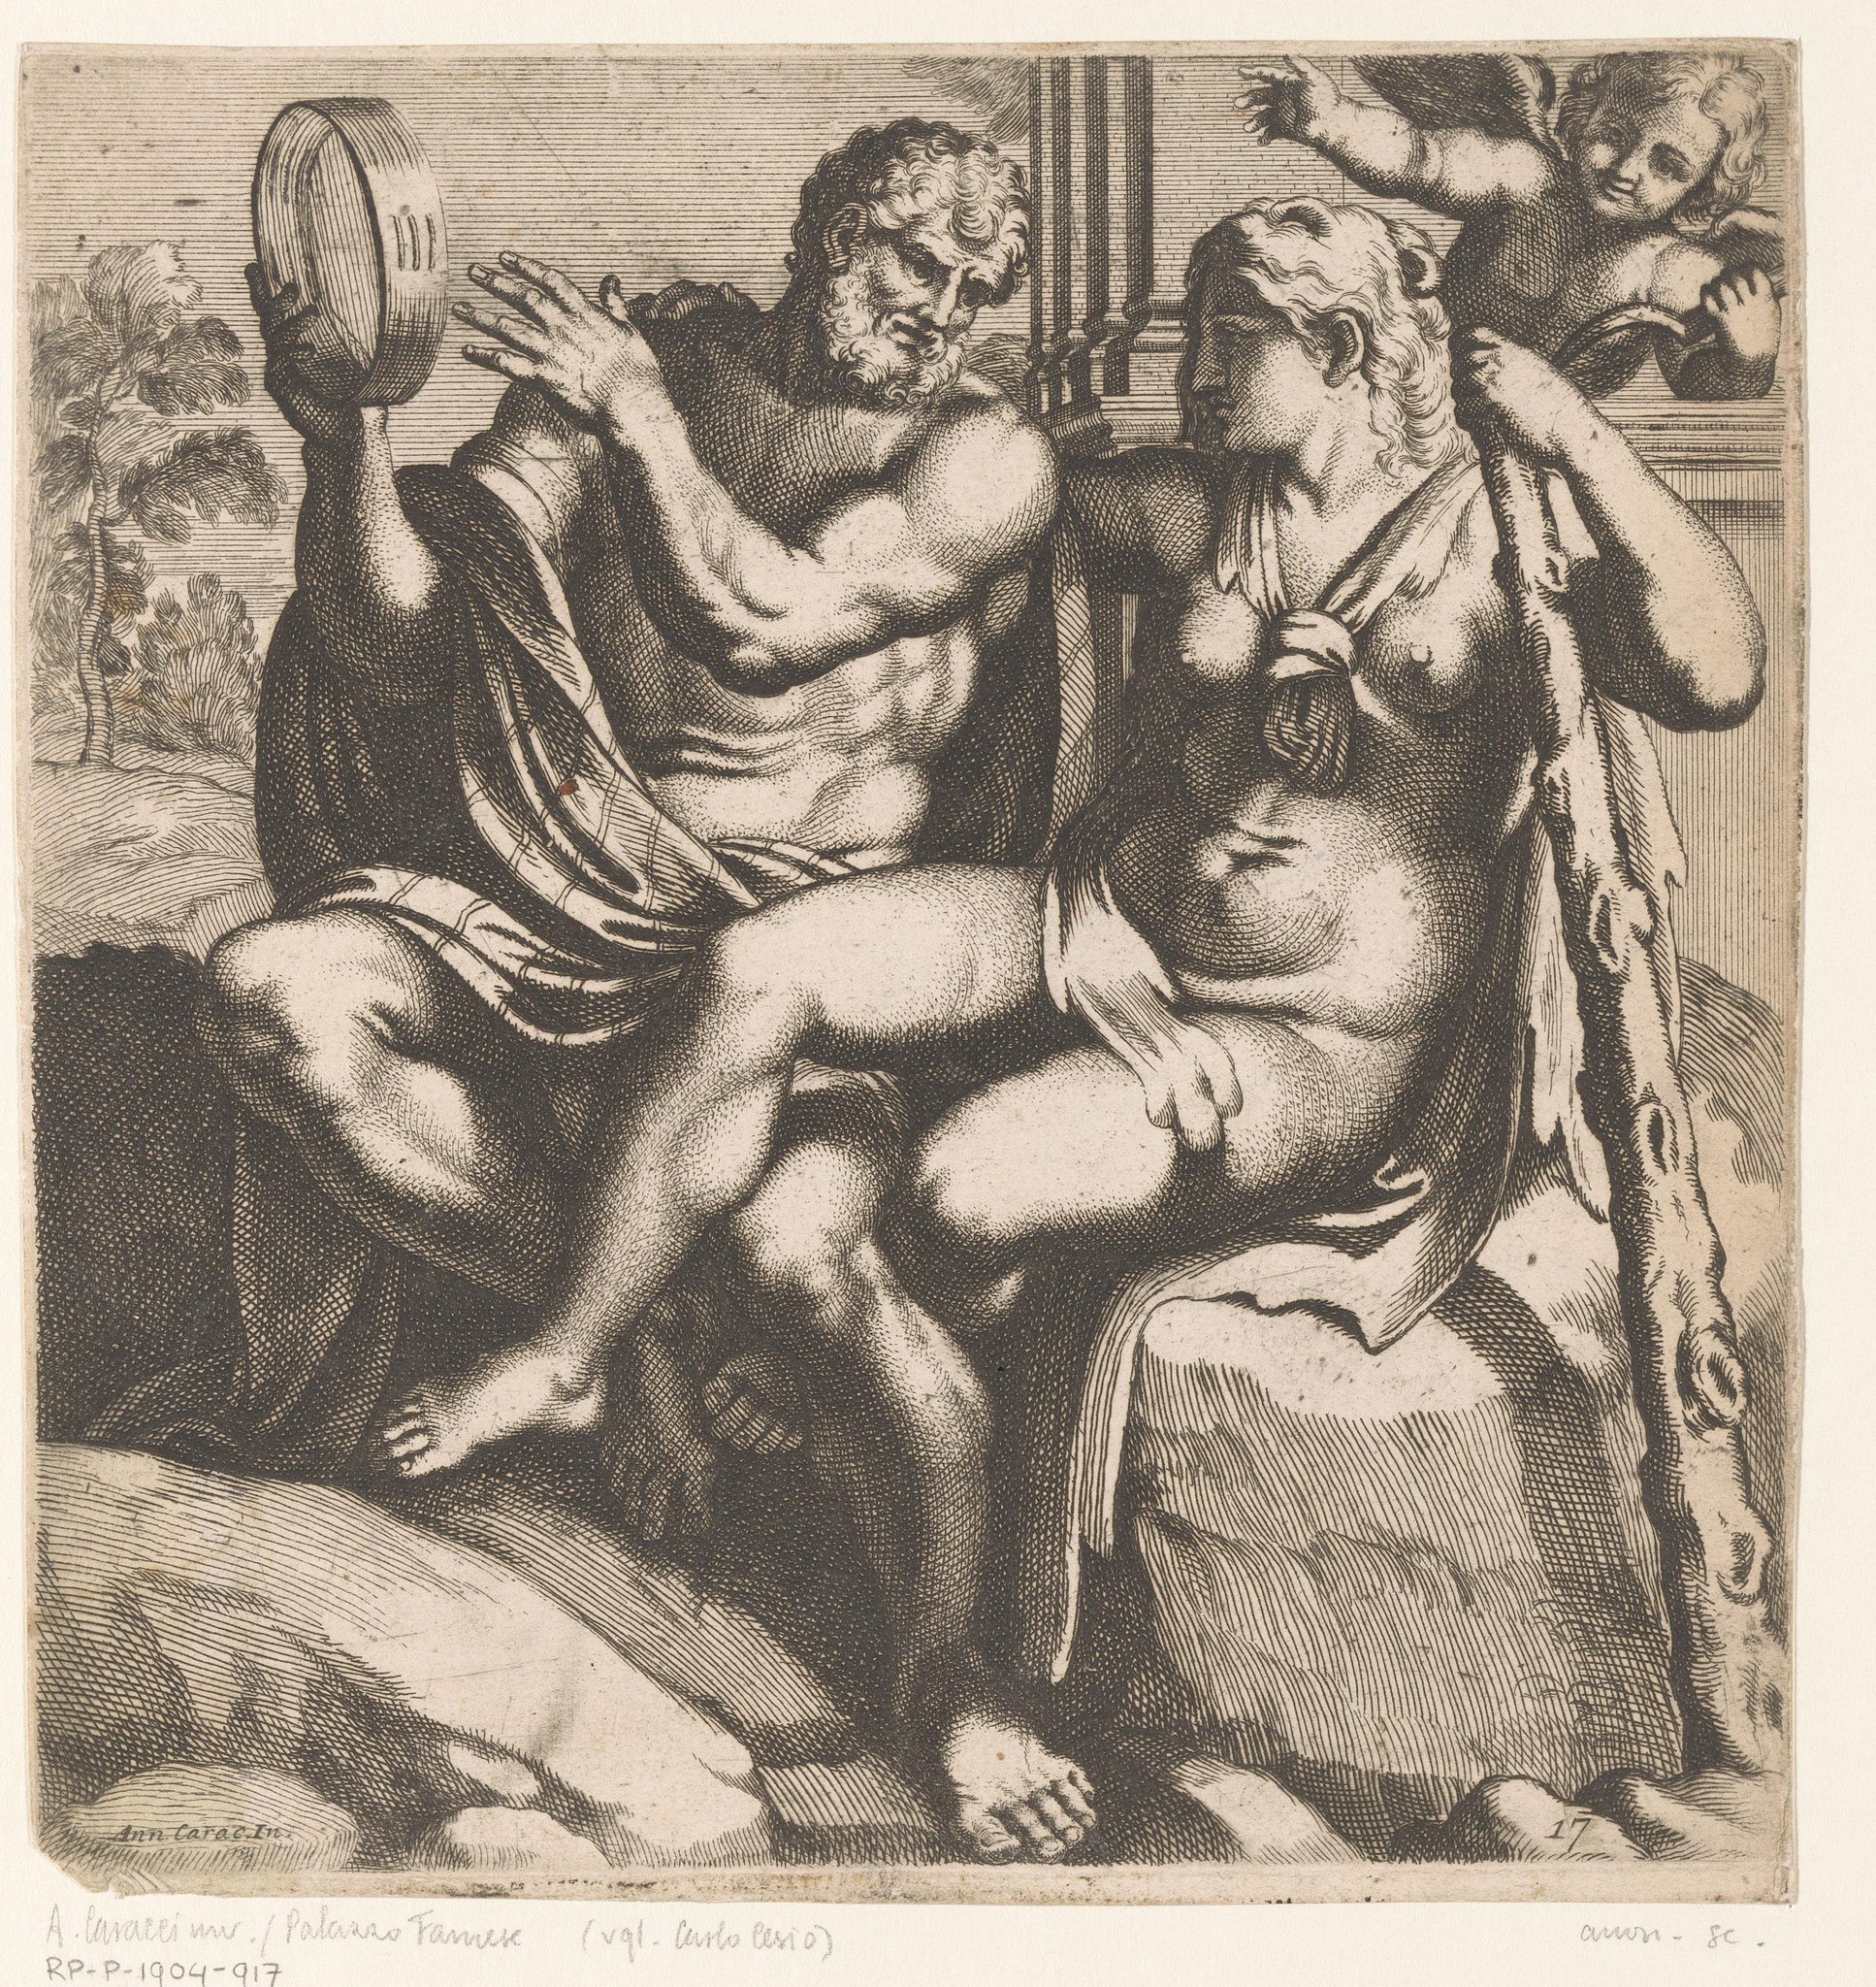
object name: print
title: Schilderingen in Palazzo Farnese te Rome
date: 1570-1659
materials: paper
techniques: etching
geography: rome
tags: hercules wooing iole, (story of) cupid, amor (eros)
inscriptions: collector's mark: Lugt 2228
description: Hercules en Iole zitten op een rots. Hercules speelt op een tamboerijn. Op de achtergrond staat Amor met zijn boog.